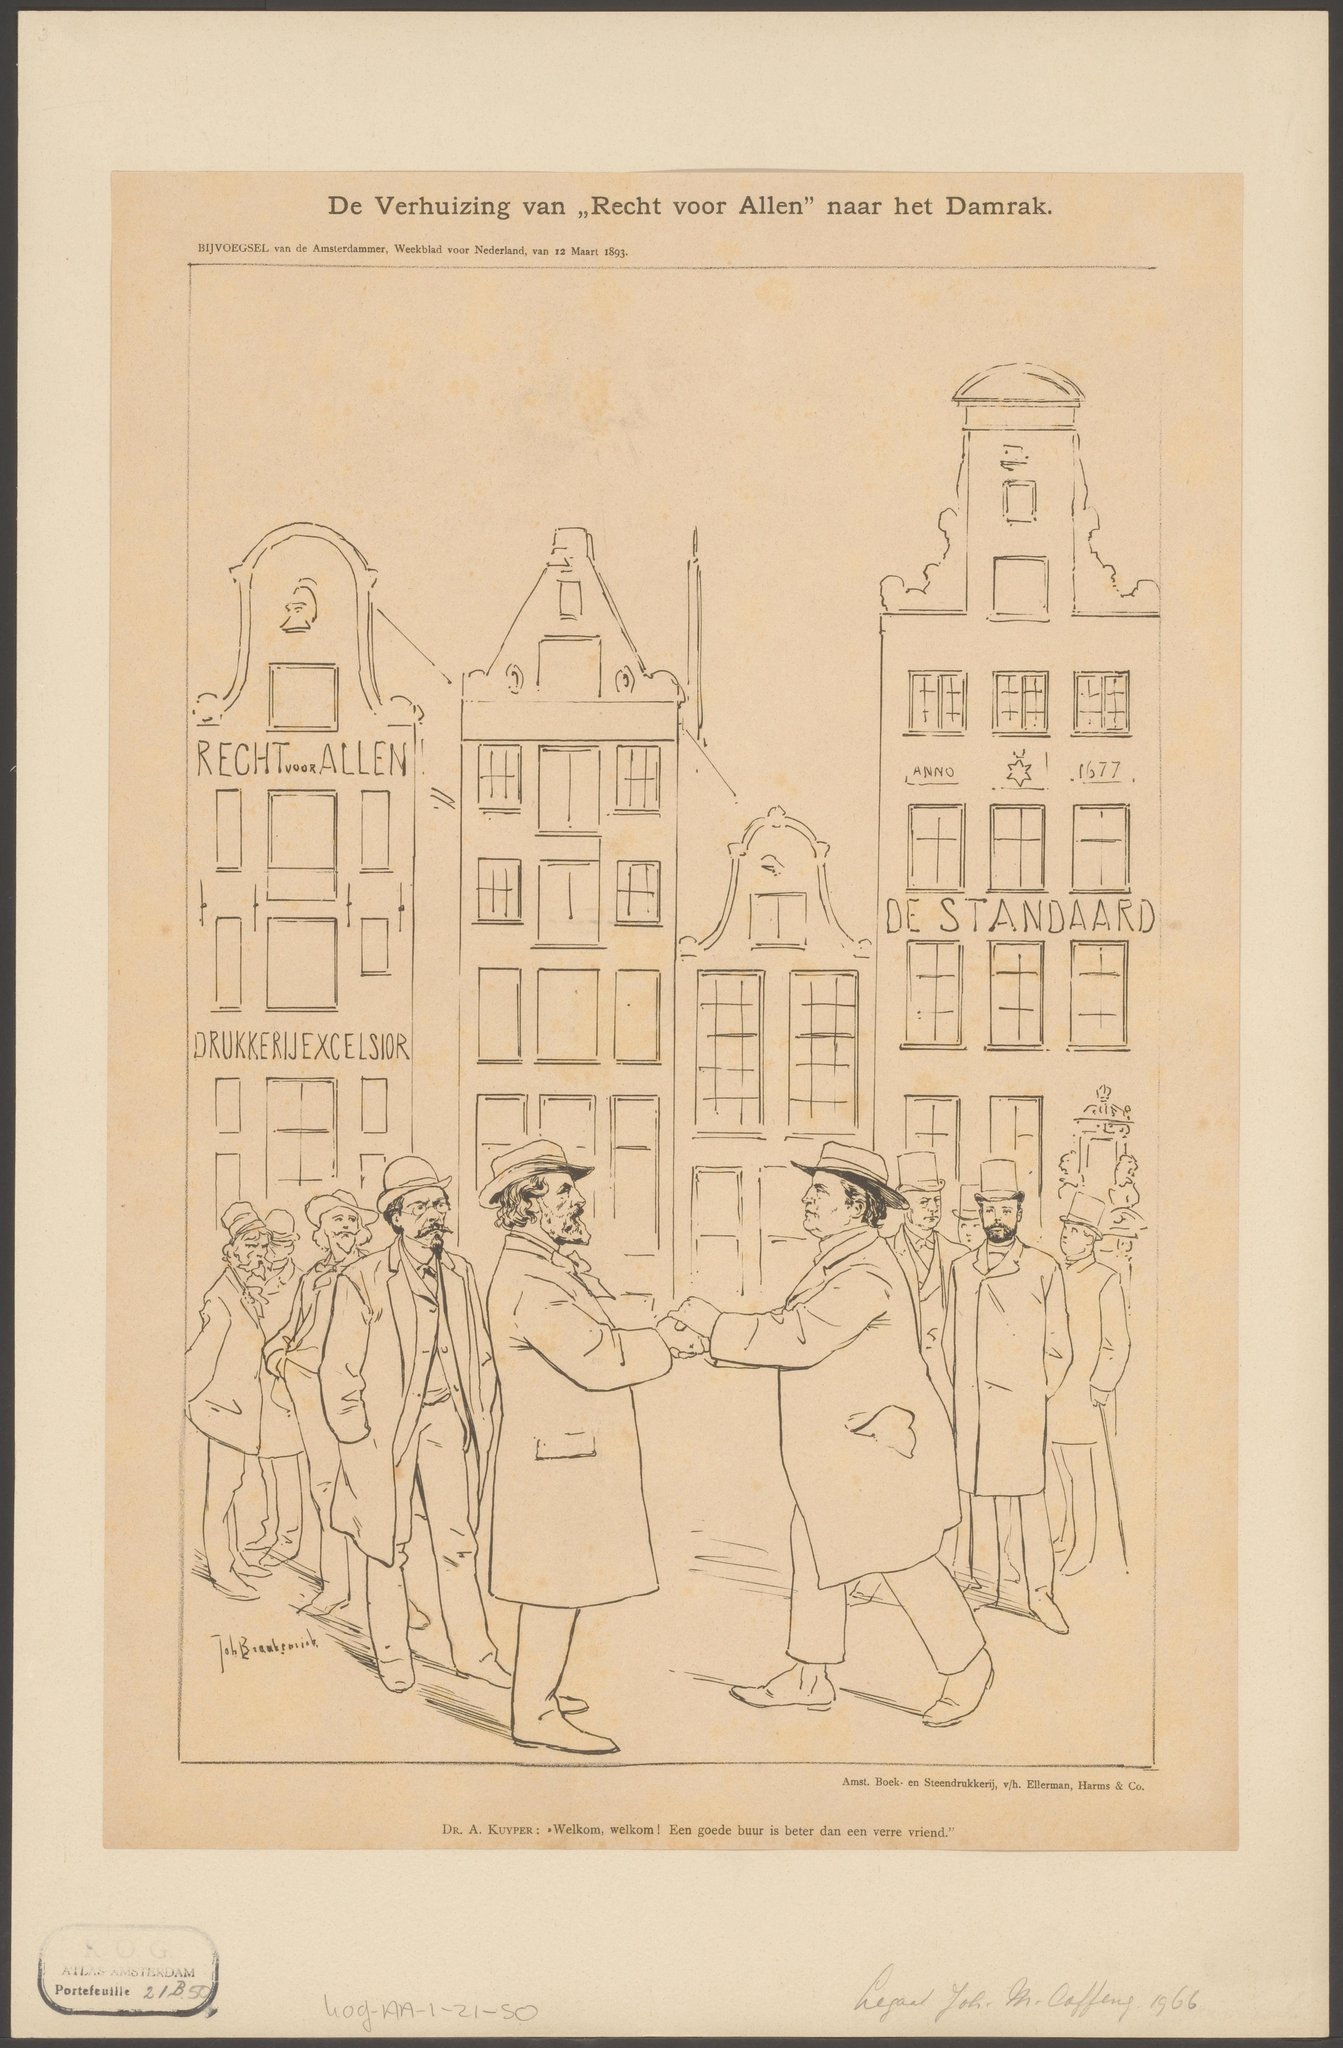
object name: cartoon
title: De Verhuizing van "Recht voor Allen" naar het Damrak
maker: johan braakensiek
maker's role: draughtsman, print maker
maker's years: 1858-1940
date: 1893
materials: paper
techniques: letterpress printing, lithograph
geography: netherlands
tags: the hague, abraham kuyper, politician, ferdinand domela nieuwenhuis, politician, e.g. party leader, newspaper, news-sheet, civic architecture; edifices; dwellings, political caricatures and satires, amsterdam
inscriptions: collector's mark: Lugt 1641b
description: Het sociaaldemocratisch tijdschrift 'Recht voor Allen' onder redactie van Ferdinand Domela Nieuwenhuis verhuist naar een pand aan het Damrak te Amsterdam en wordt daar welkom geheten door Abraham Kuyper van het antirevolutionaire tijdschrift 'De Standaard'. Onderwerpsrubriek binnen de Atlas Amsterdam: Kiesverenigingen, Politieke partijen.